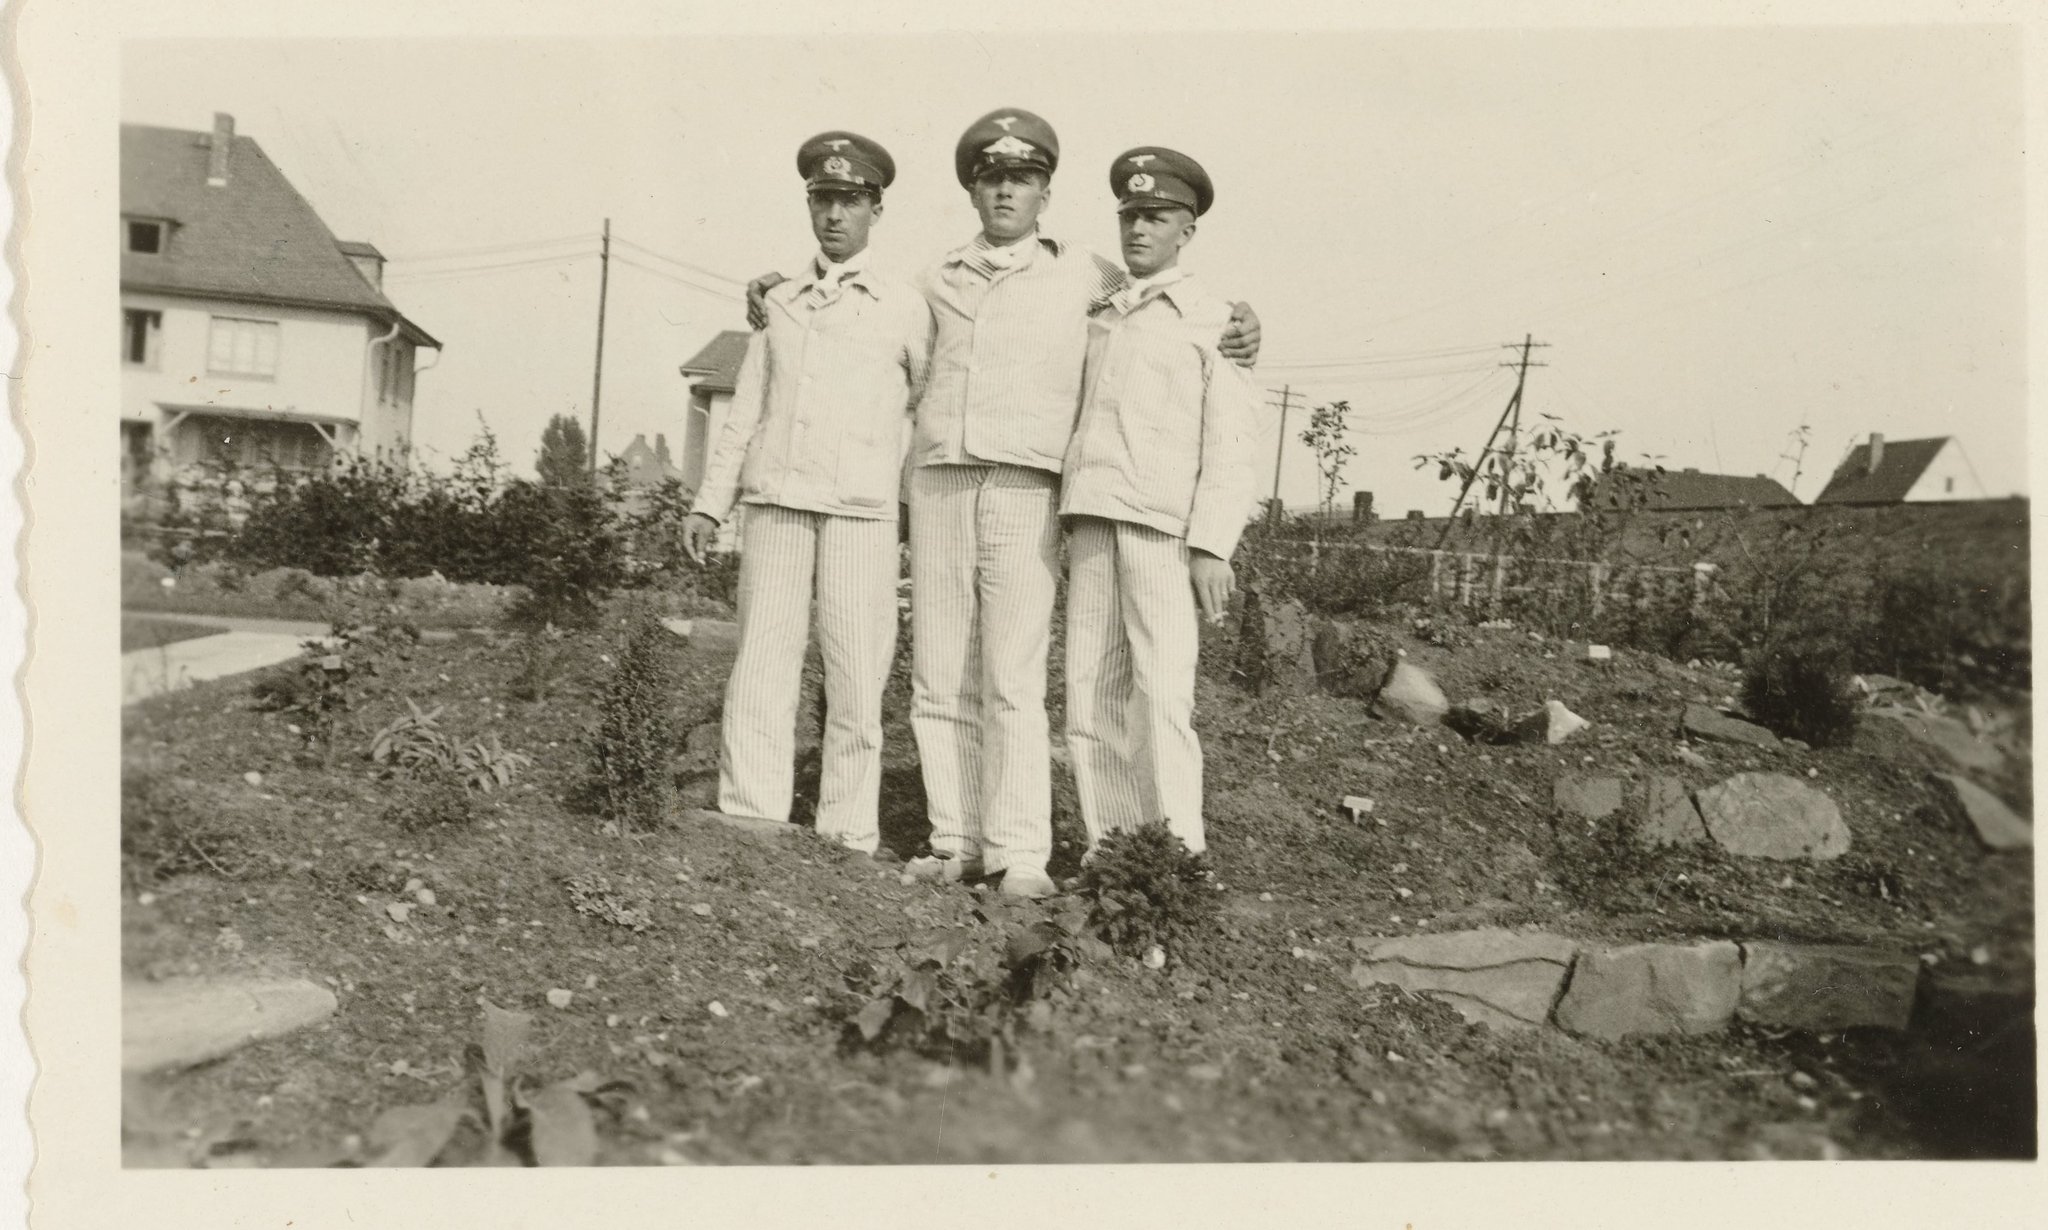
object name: photograph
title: Drie Wehrmachtsoldaten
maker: Anonymous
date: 1940-1945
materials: photographic support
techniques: gelatin silver print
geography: czechoslovakia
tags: netherlands, germany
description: Drie Wehrmachtsoldaten in een lichtkleurig uniform. Achterop staat: August 1937, Gross-Hamburg?. Foto behorend bij album 'Kriegserinnerungen'.